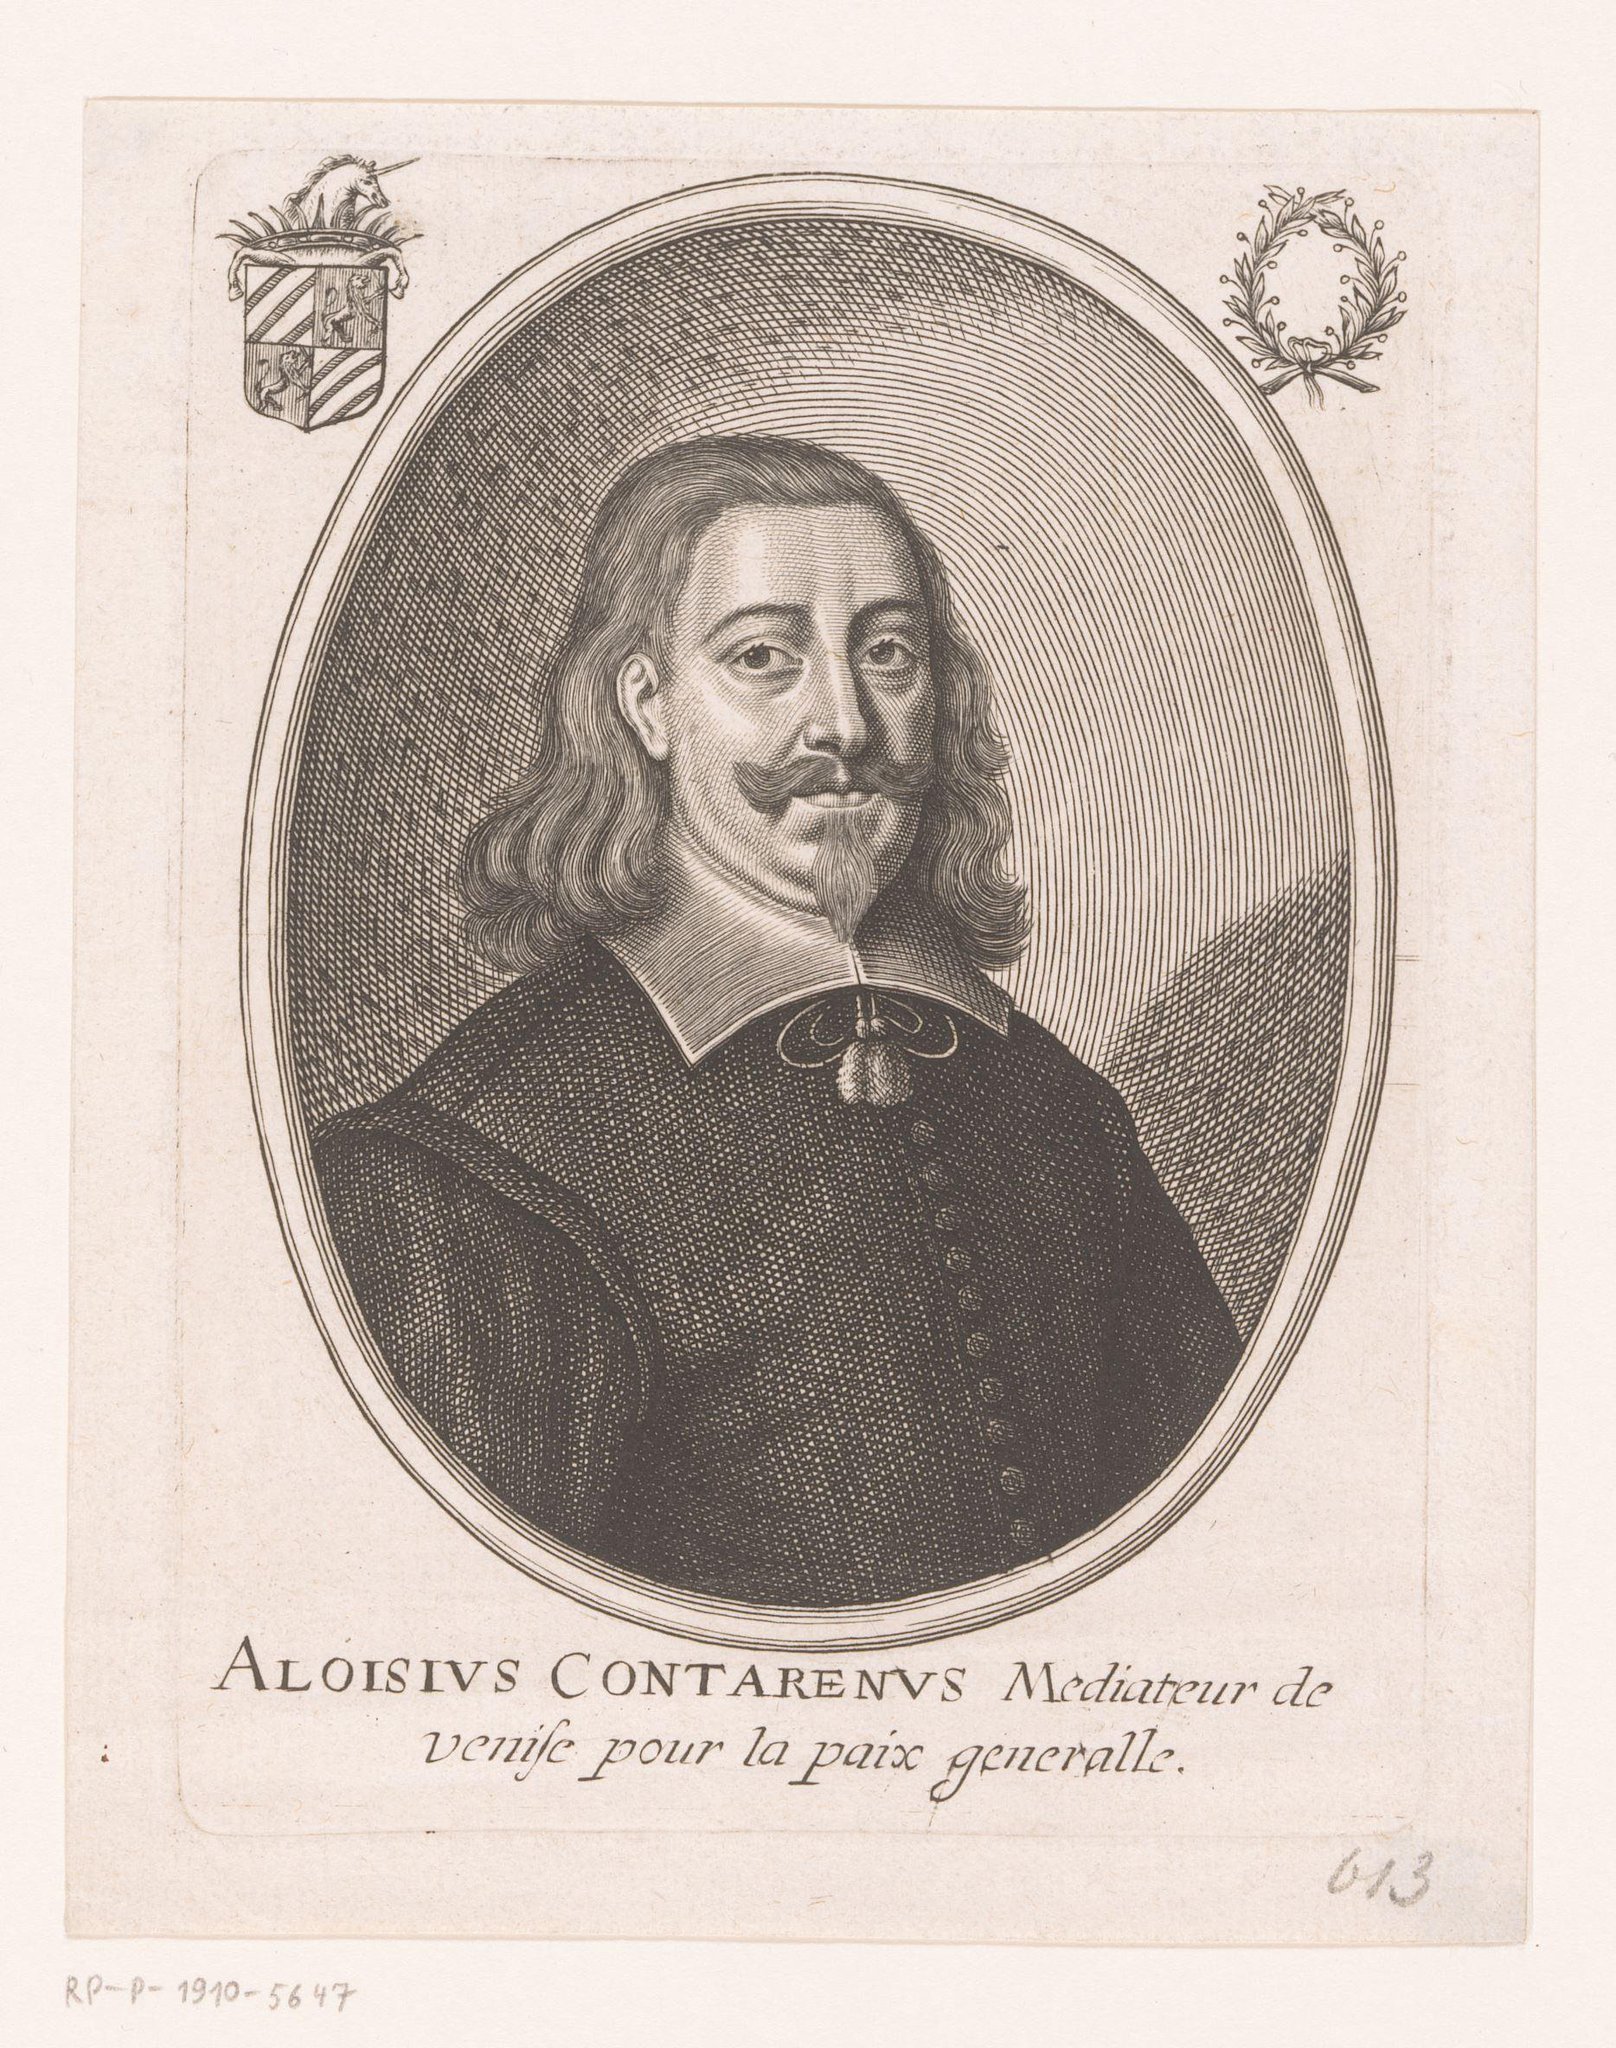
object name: print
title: Portret van Alvise Contarini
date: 1632-1668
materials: paper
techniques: engraving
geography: paris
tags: historical persons, diplomacy, diplomat, other sovereign: doge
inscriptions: collector's mark: Lugt 2228